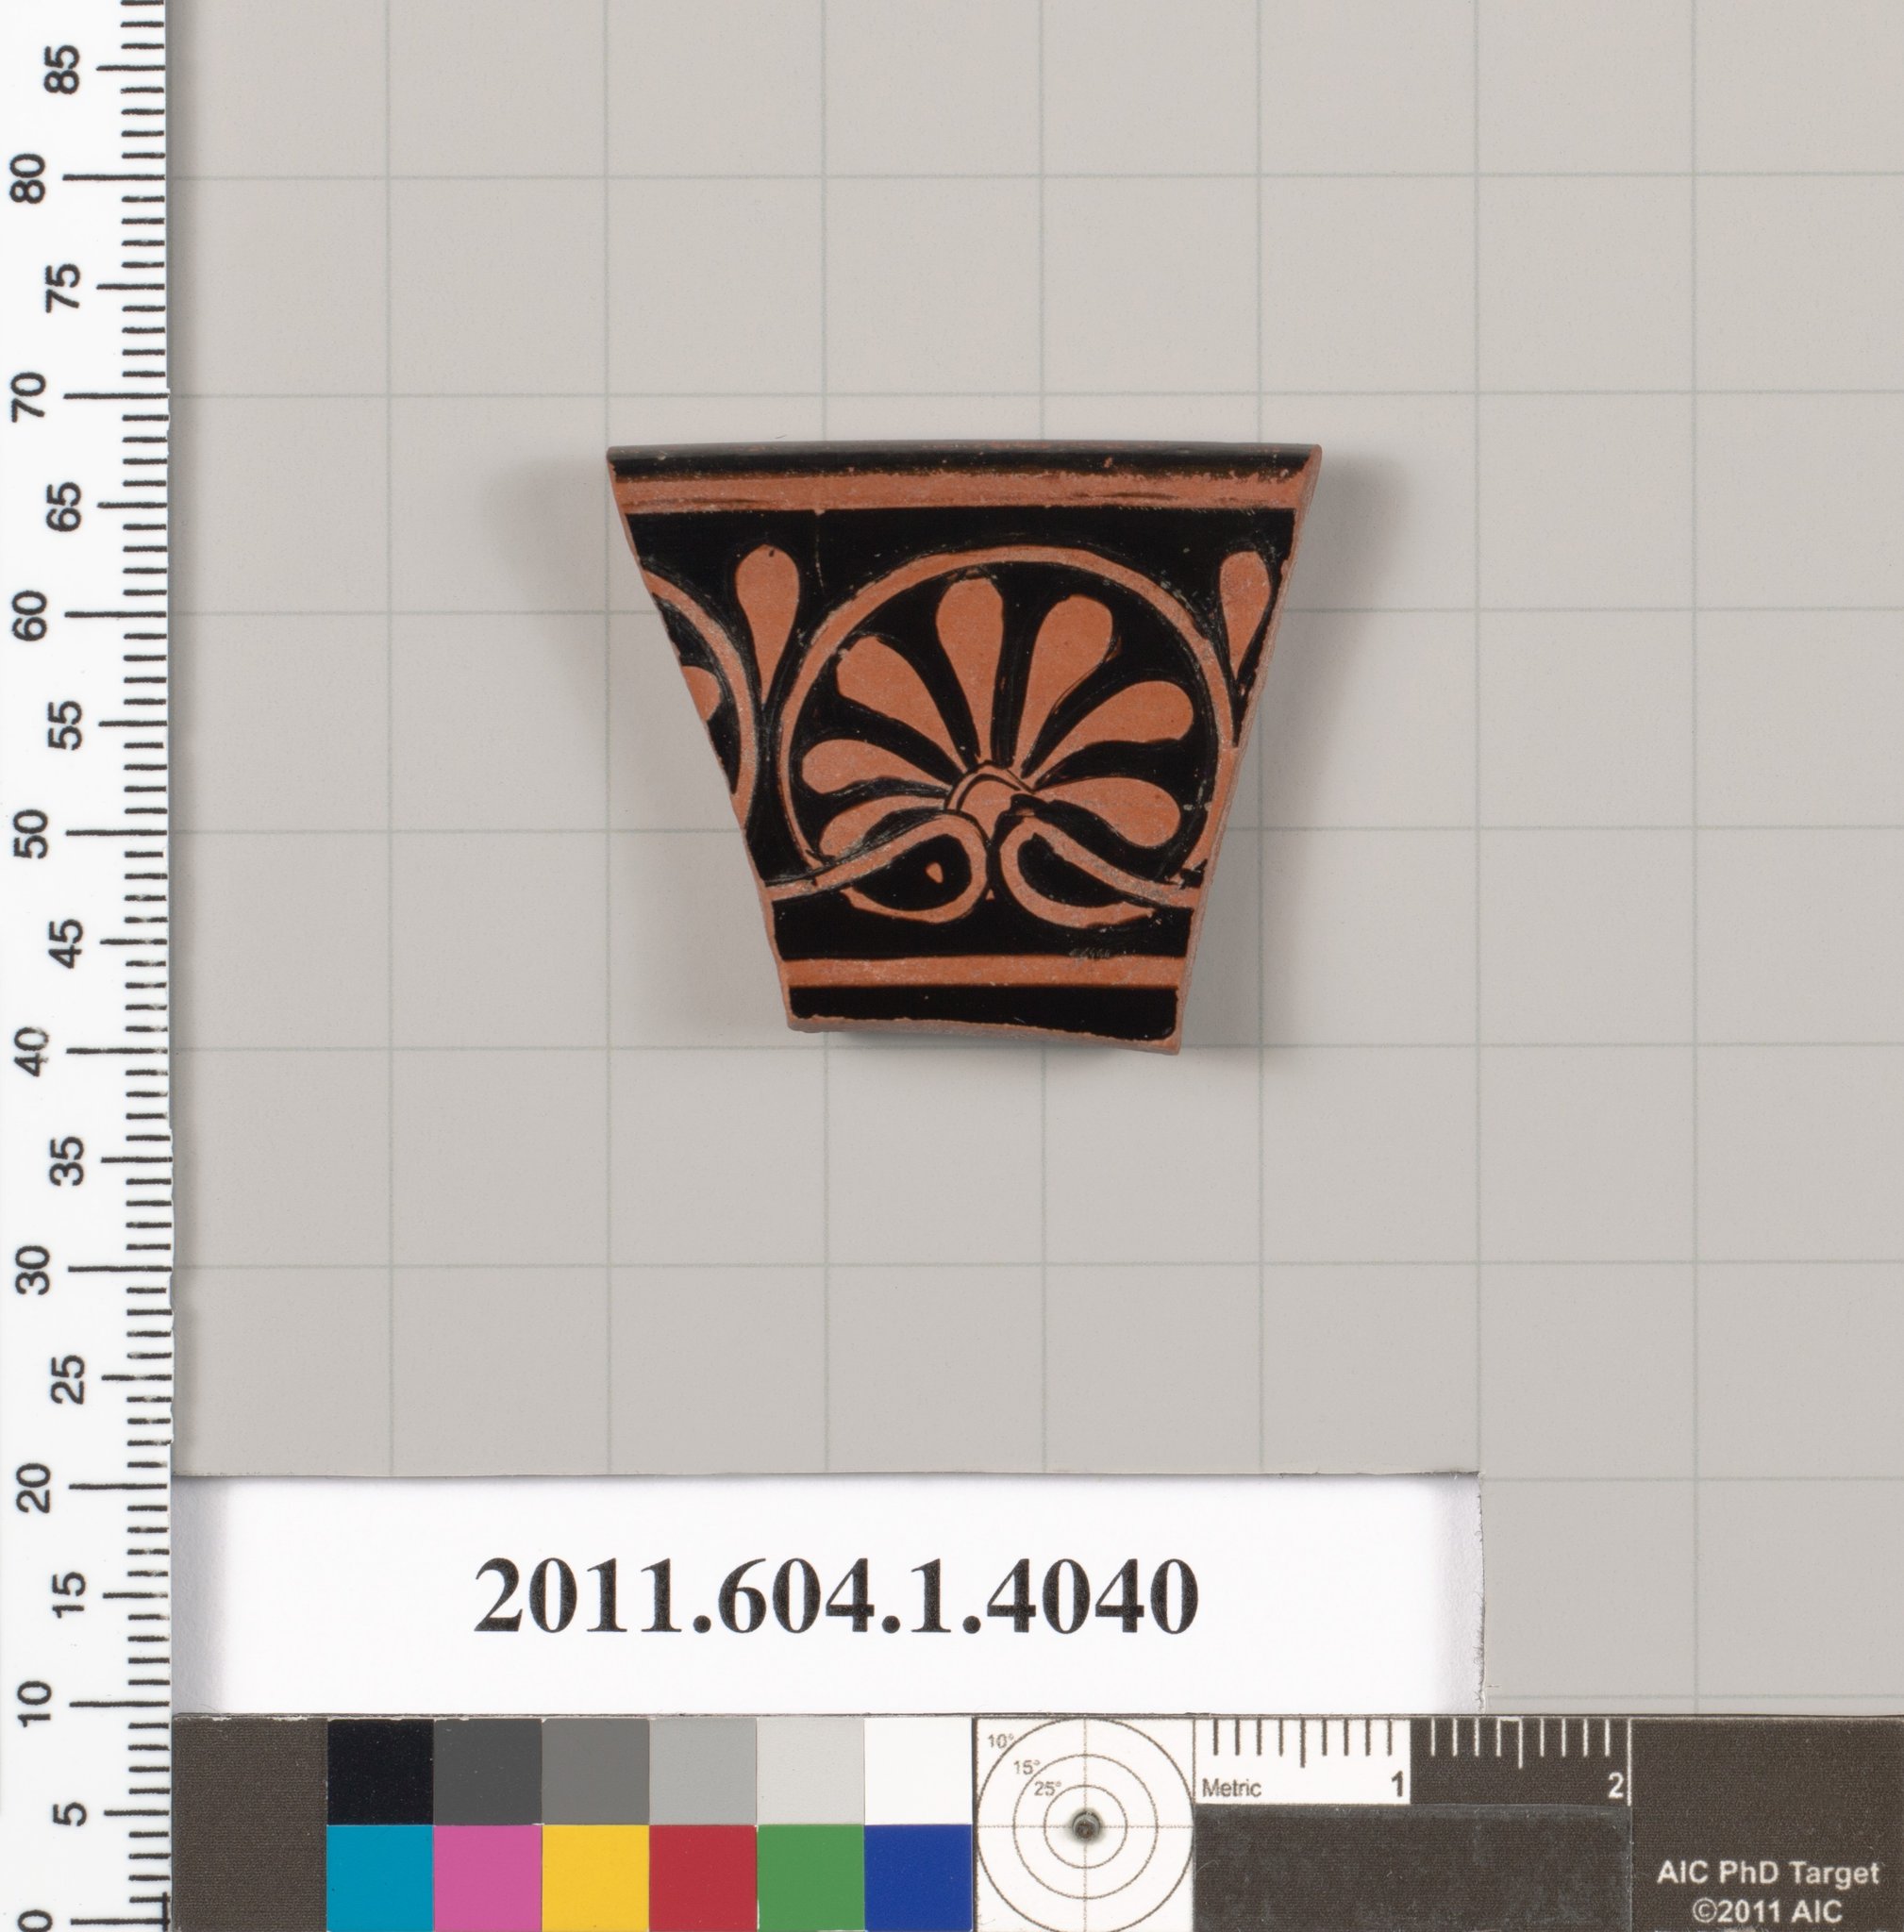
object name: kylix fragment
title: Terracotta fragment of a kylix (drinking cup)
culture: greek, attic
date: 534-468 BCE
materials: terracotta